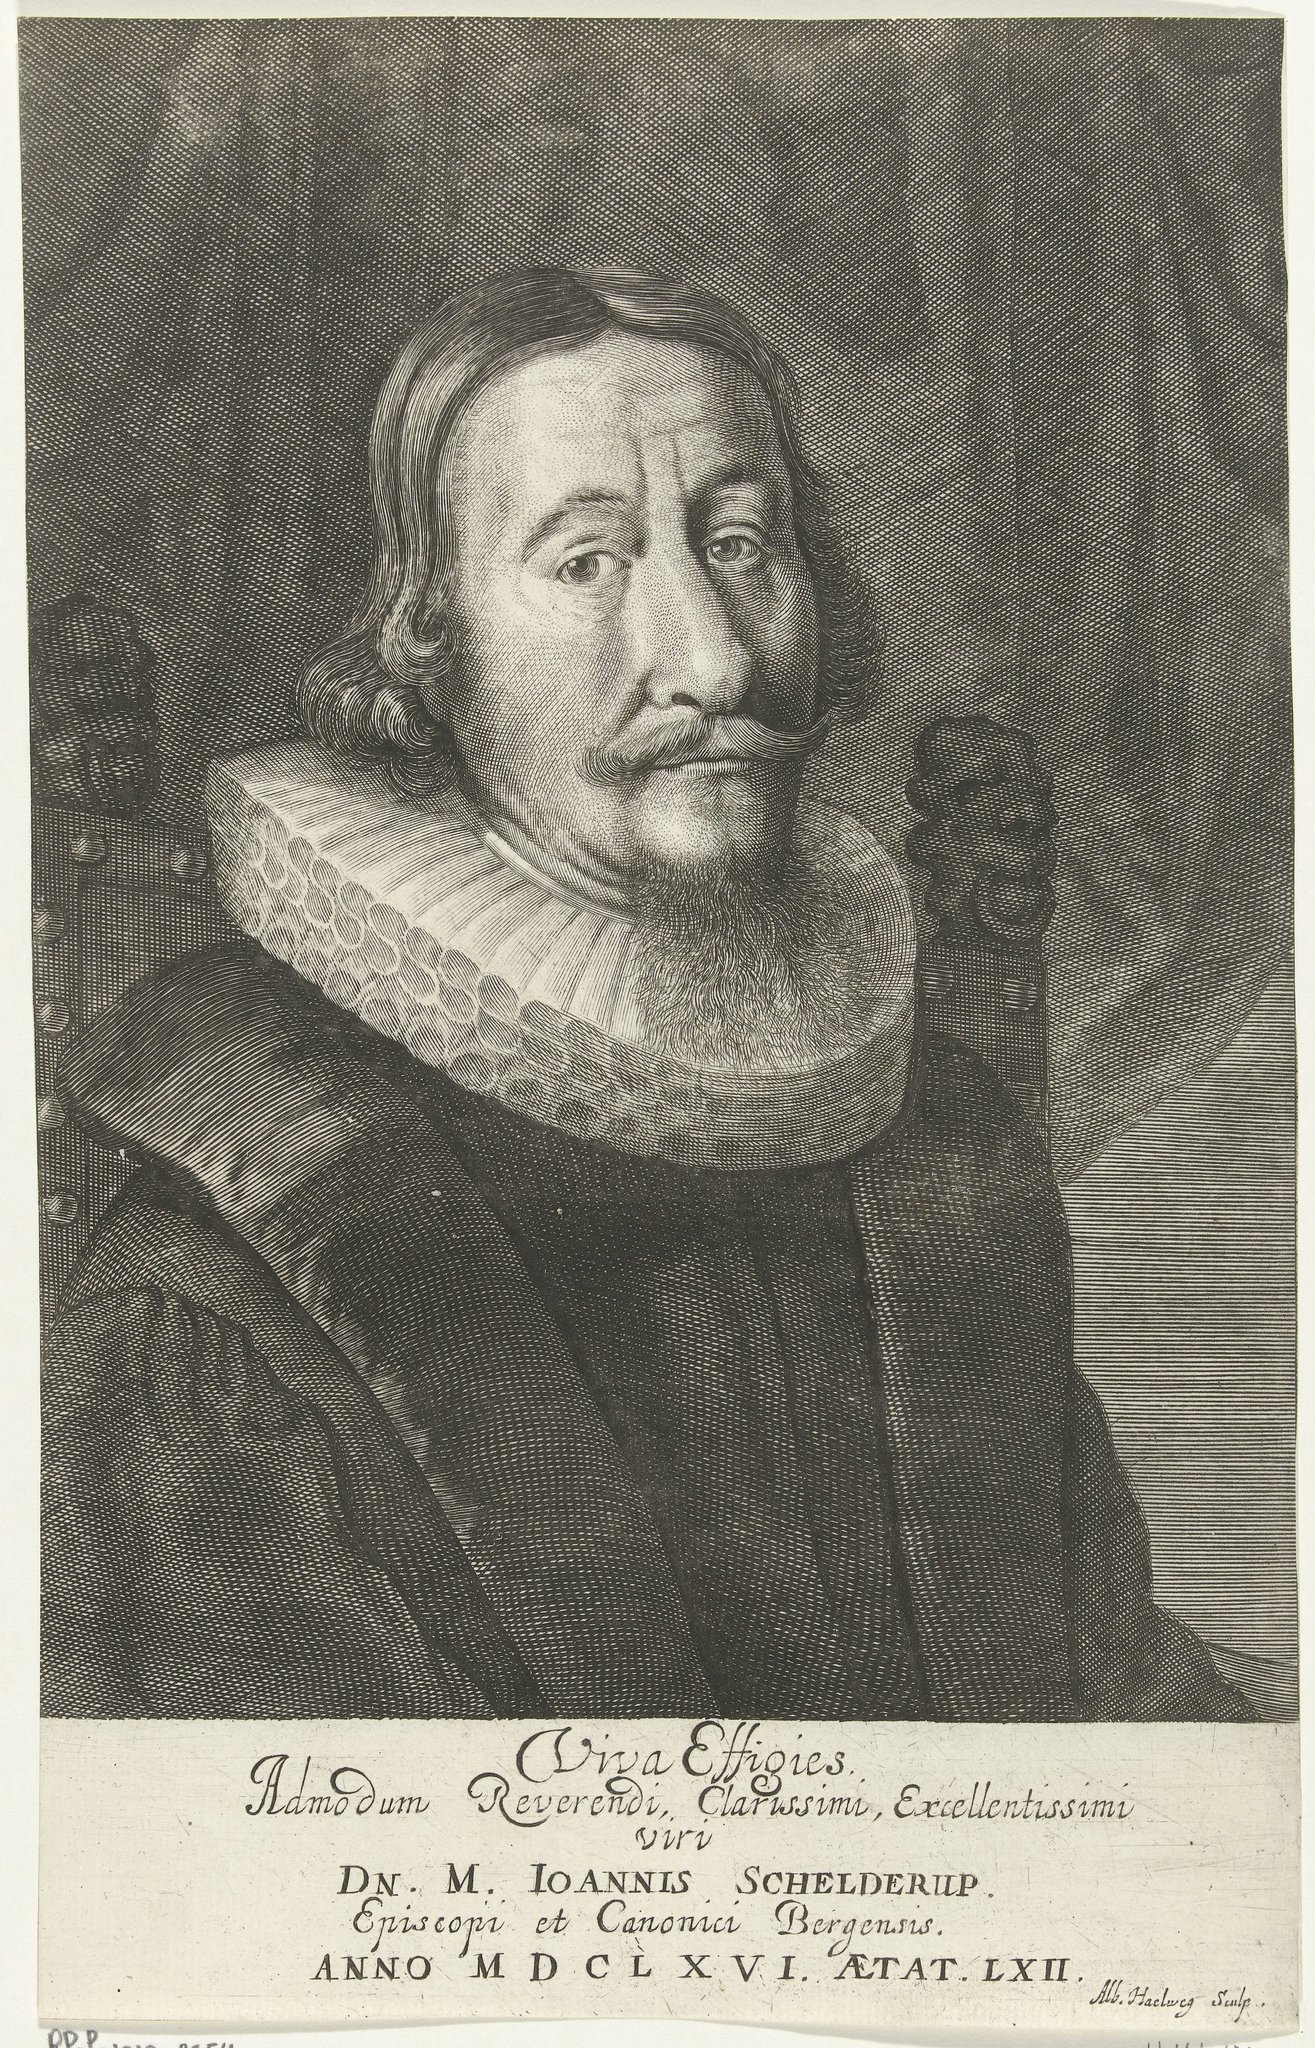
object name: print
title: Portret van Johan Schelderup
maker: albert haelwegh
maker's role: painter, print maker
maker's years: 1590-1673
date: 1666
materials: paper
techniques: engraving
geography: copenhagen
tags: moustache, chair, beard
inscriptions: collector's mark: Lugt 2228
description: Portret naar rechts van Johan Schelderup, 62 jaar oud, op een stoel.